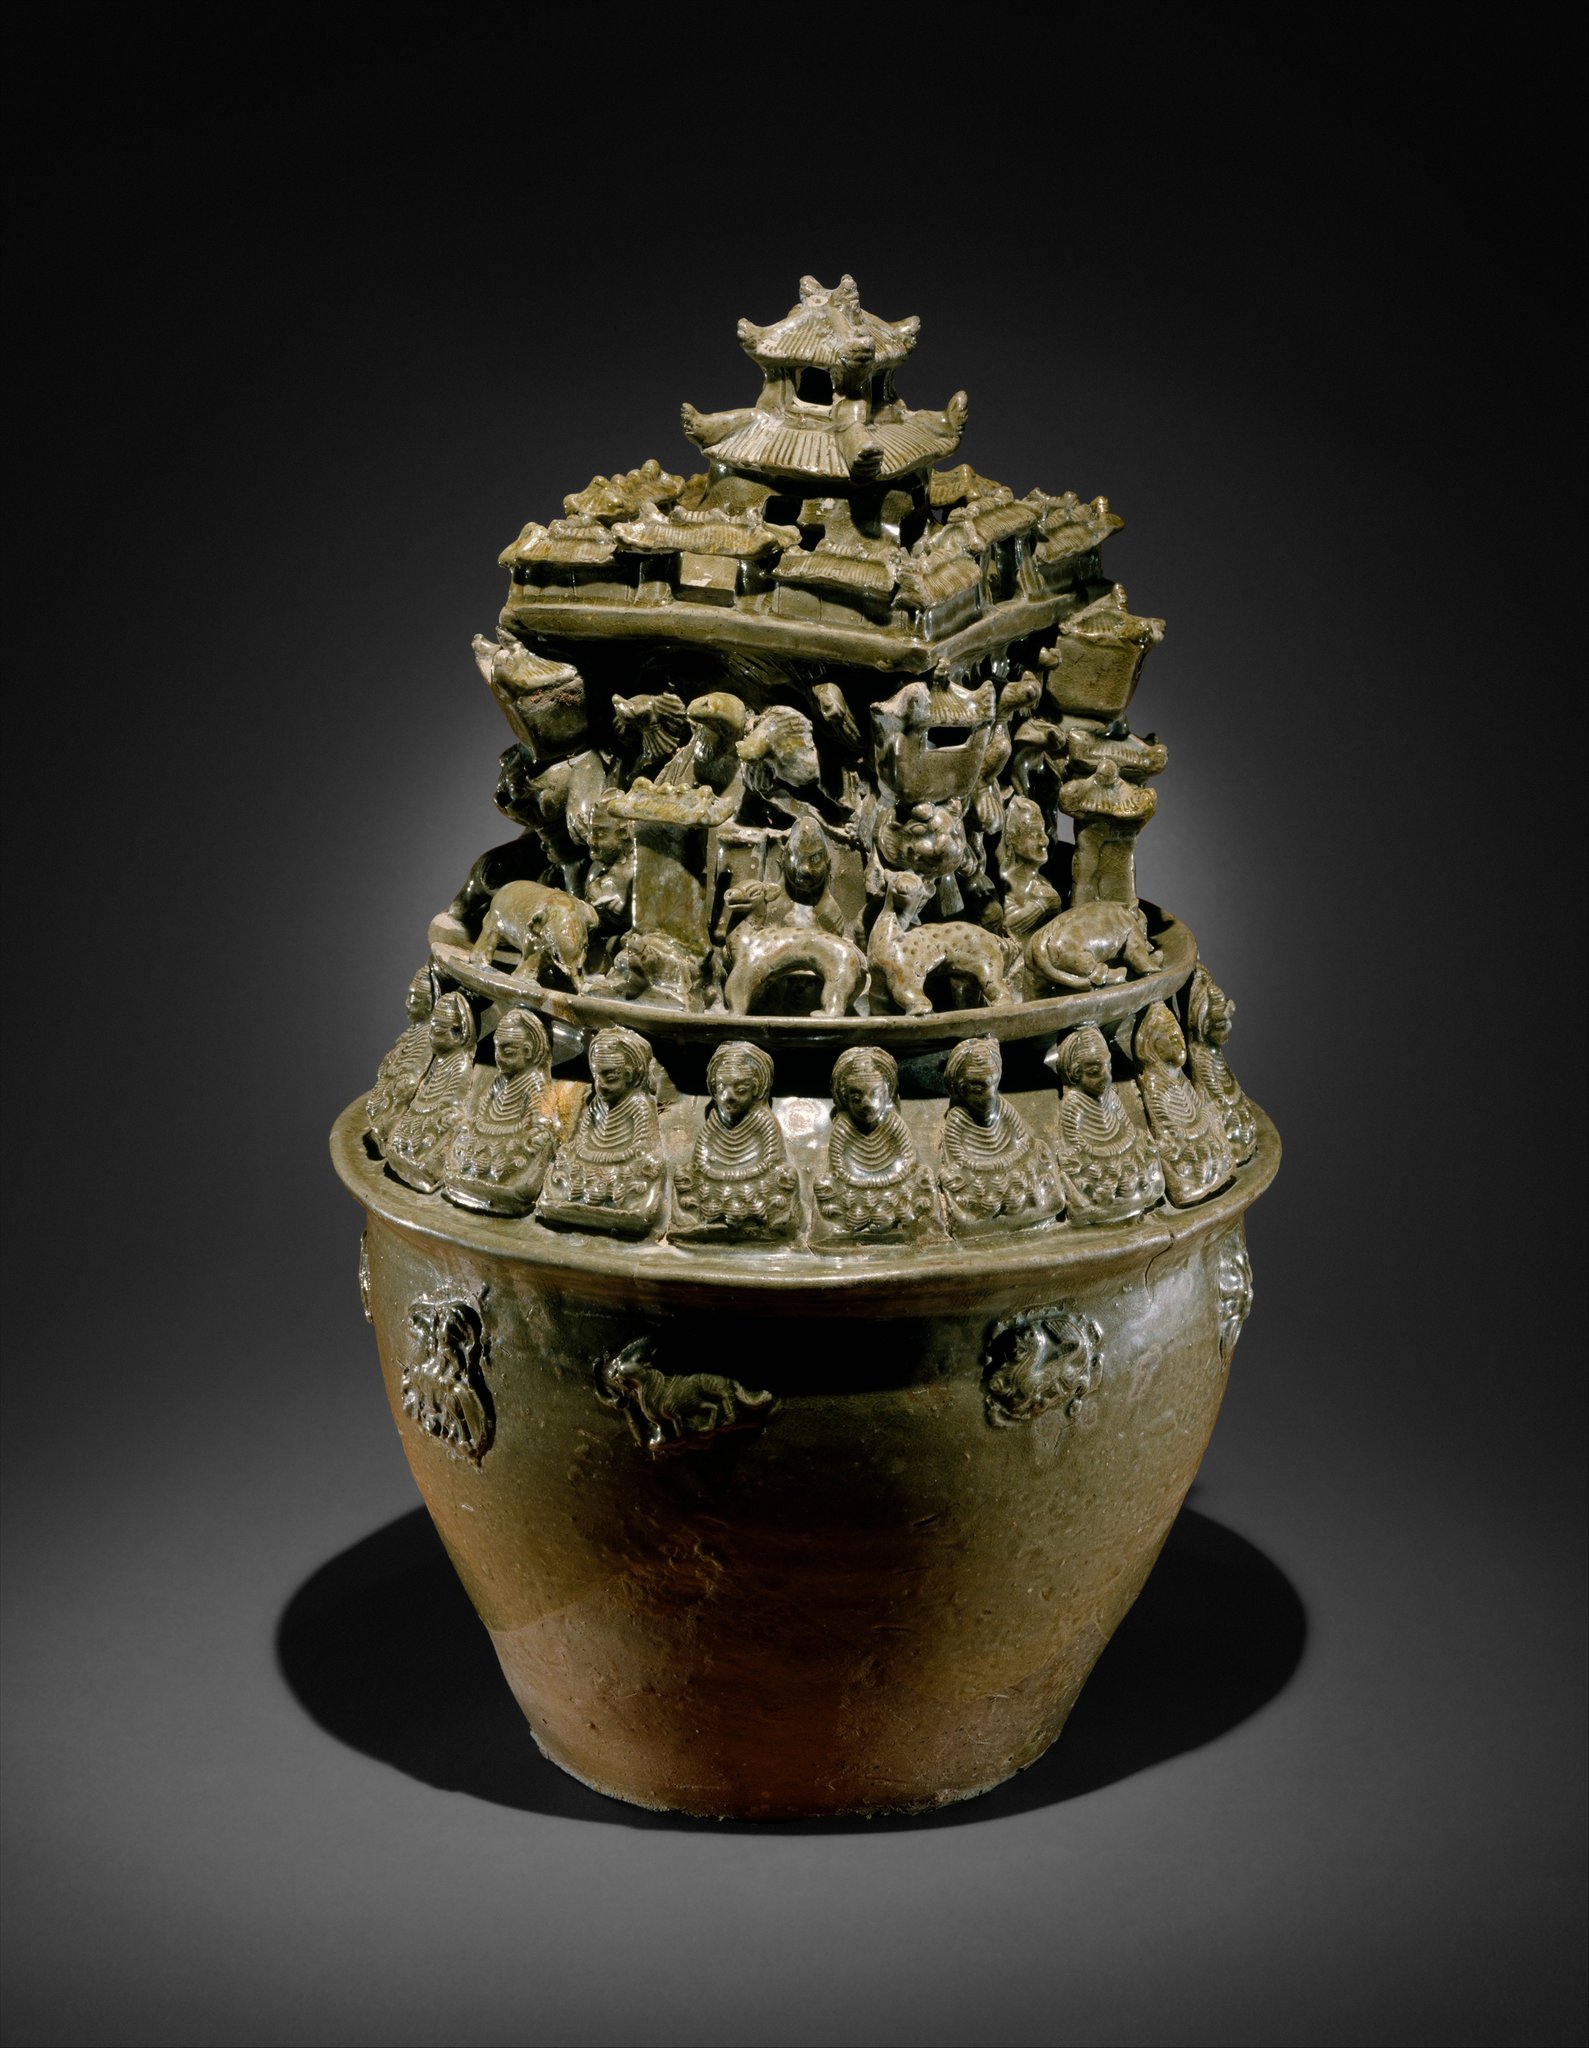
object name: funerary urn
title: Funerary Urn (Hunping)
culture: chinese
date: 265-316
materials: glaze, stoneware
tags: human figures,animals,birds,elephants